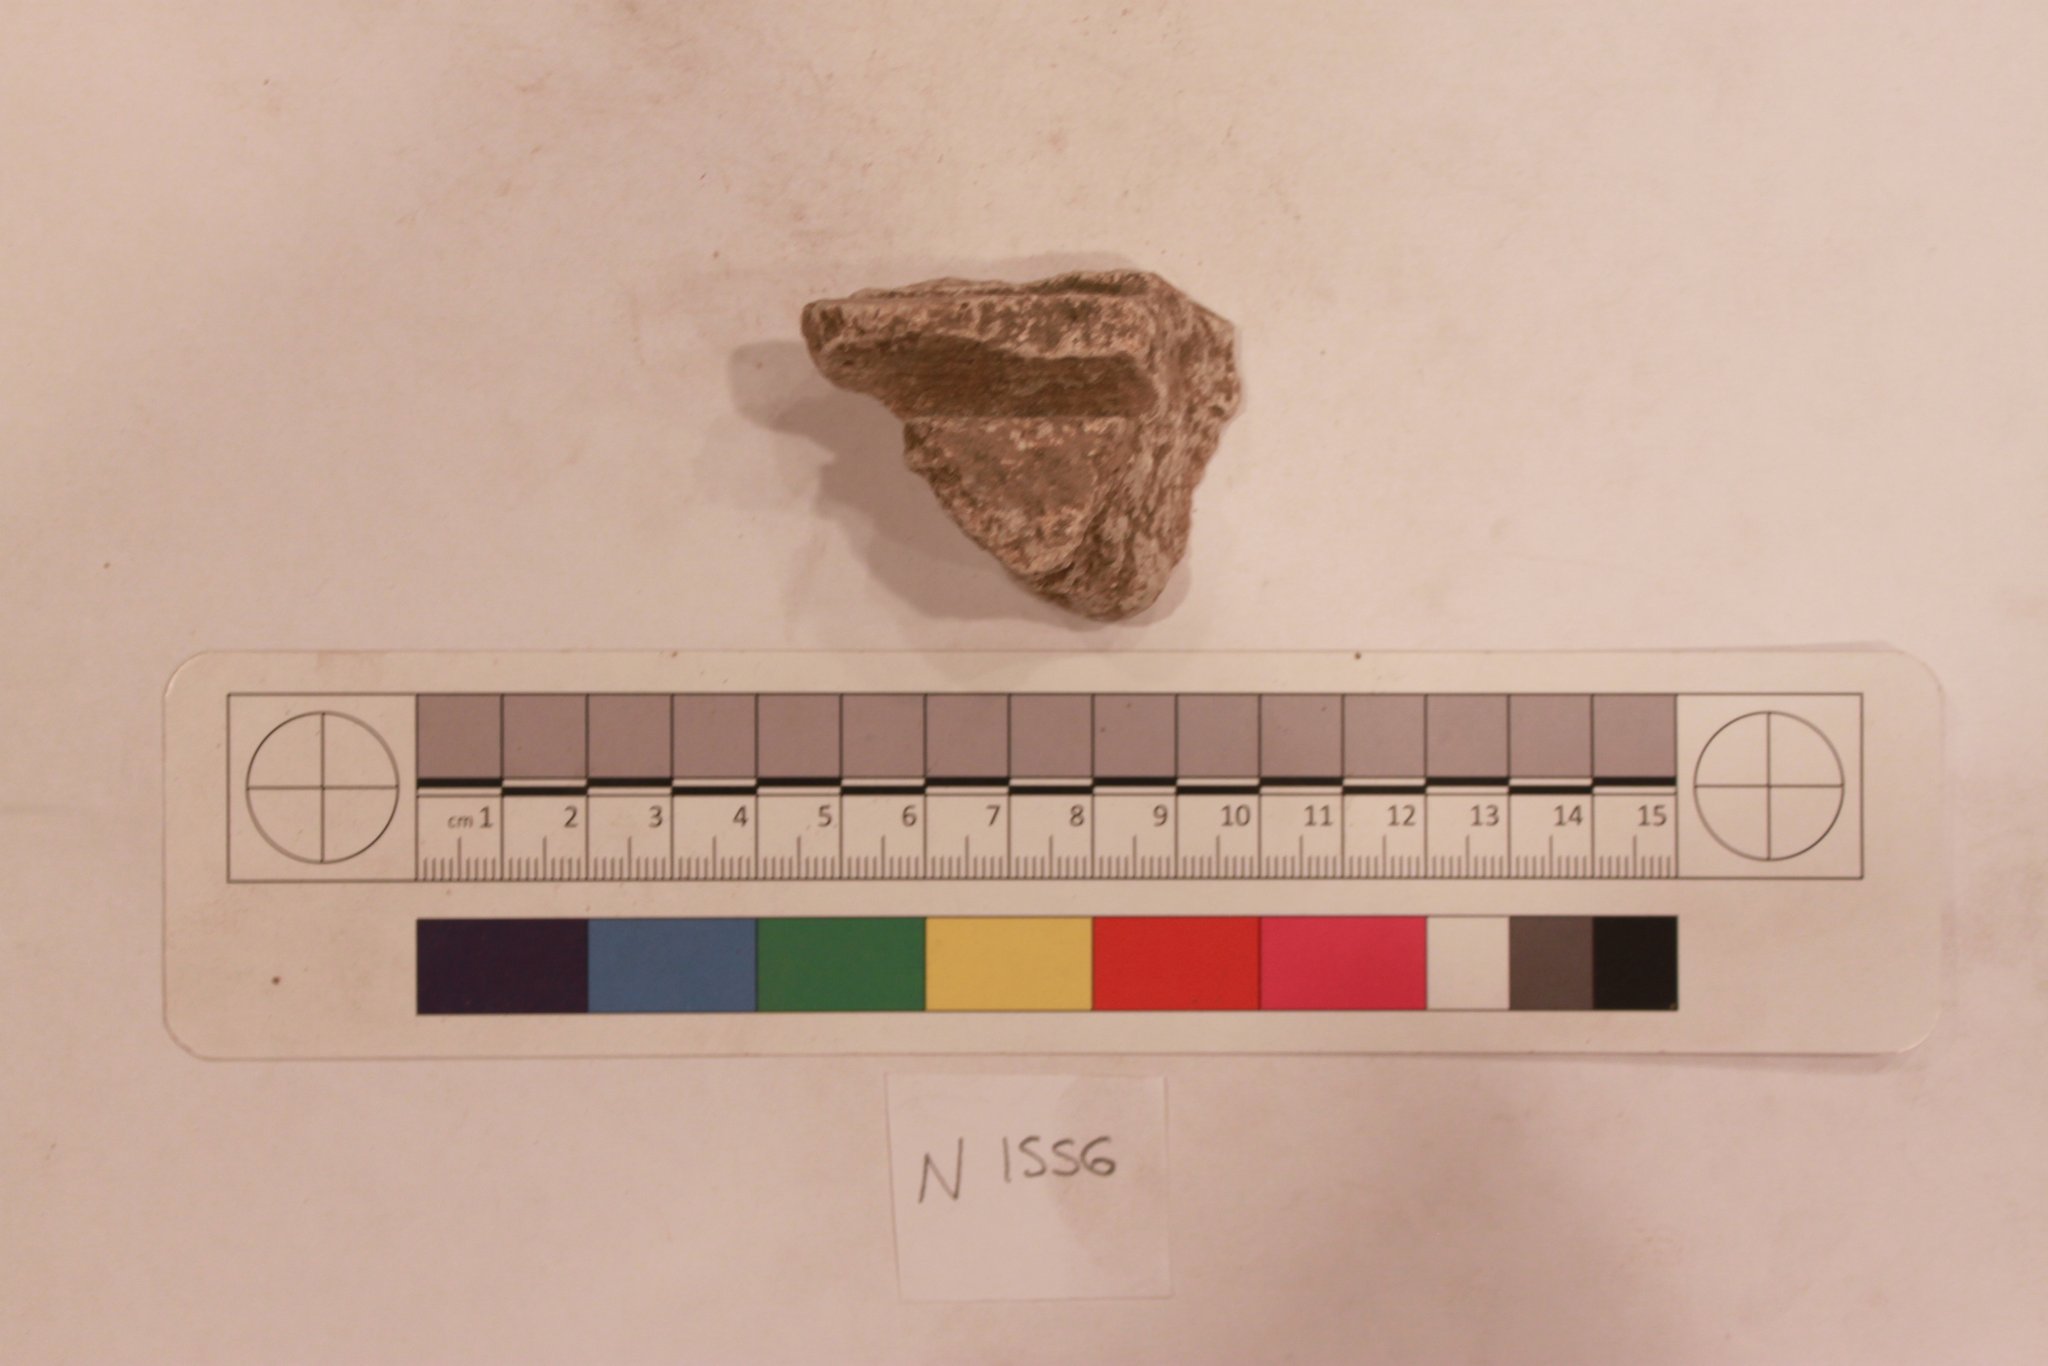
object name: fragment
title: Stucco Fragment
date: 701-1200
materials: plaster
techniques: carving, painting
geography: iran